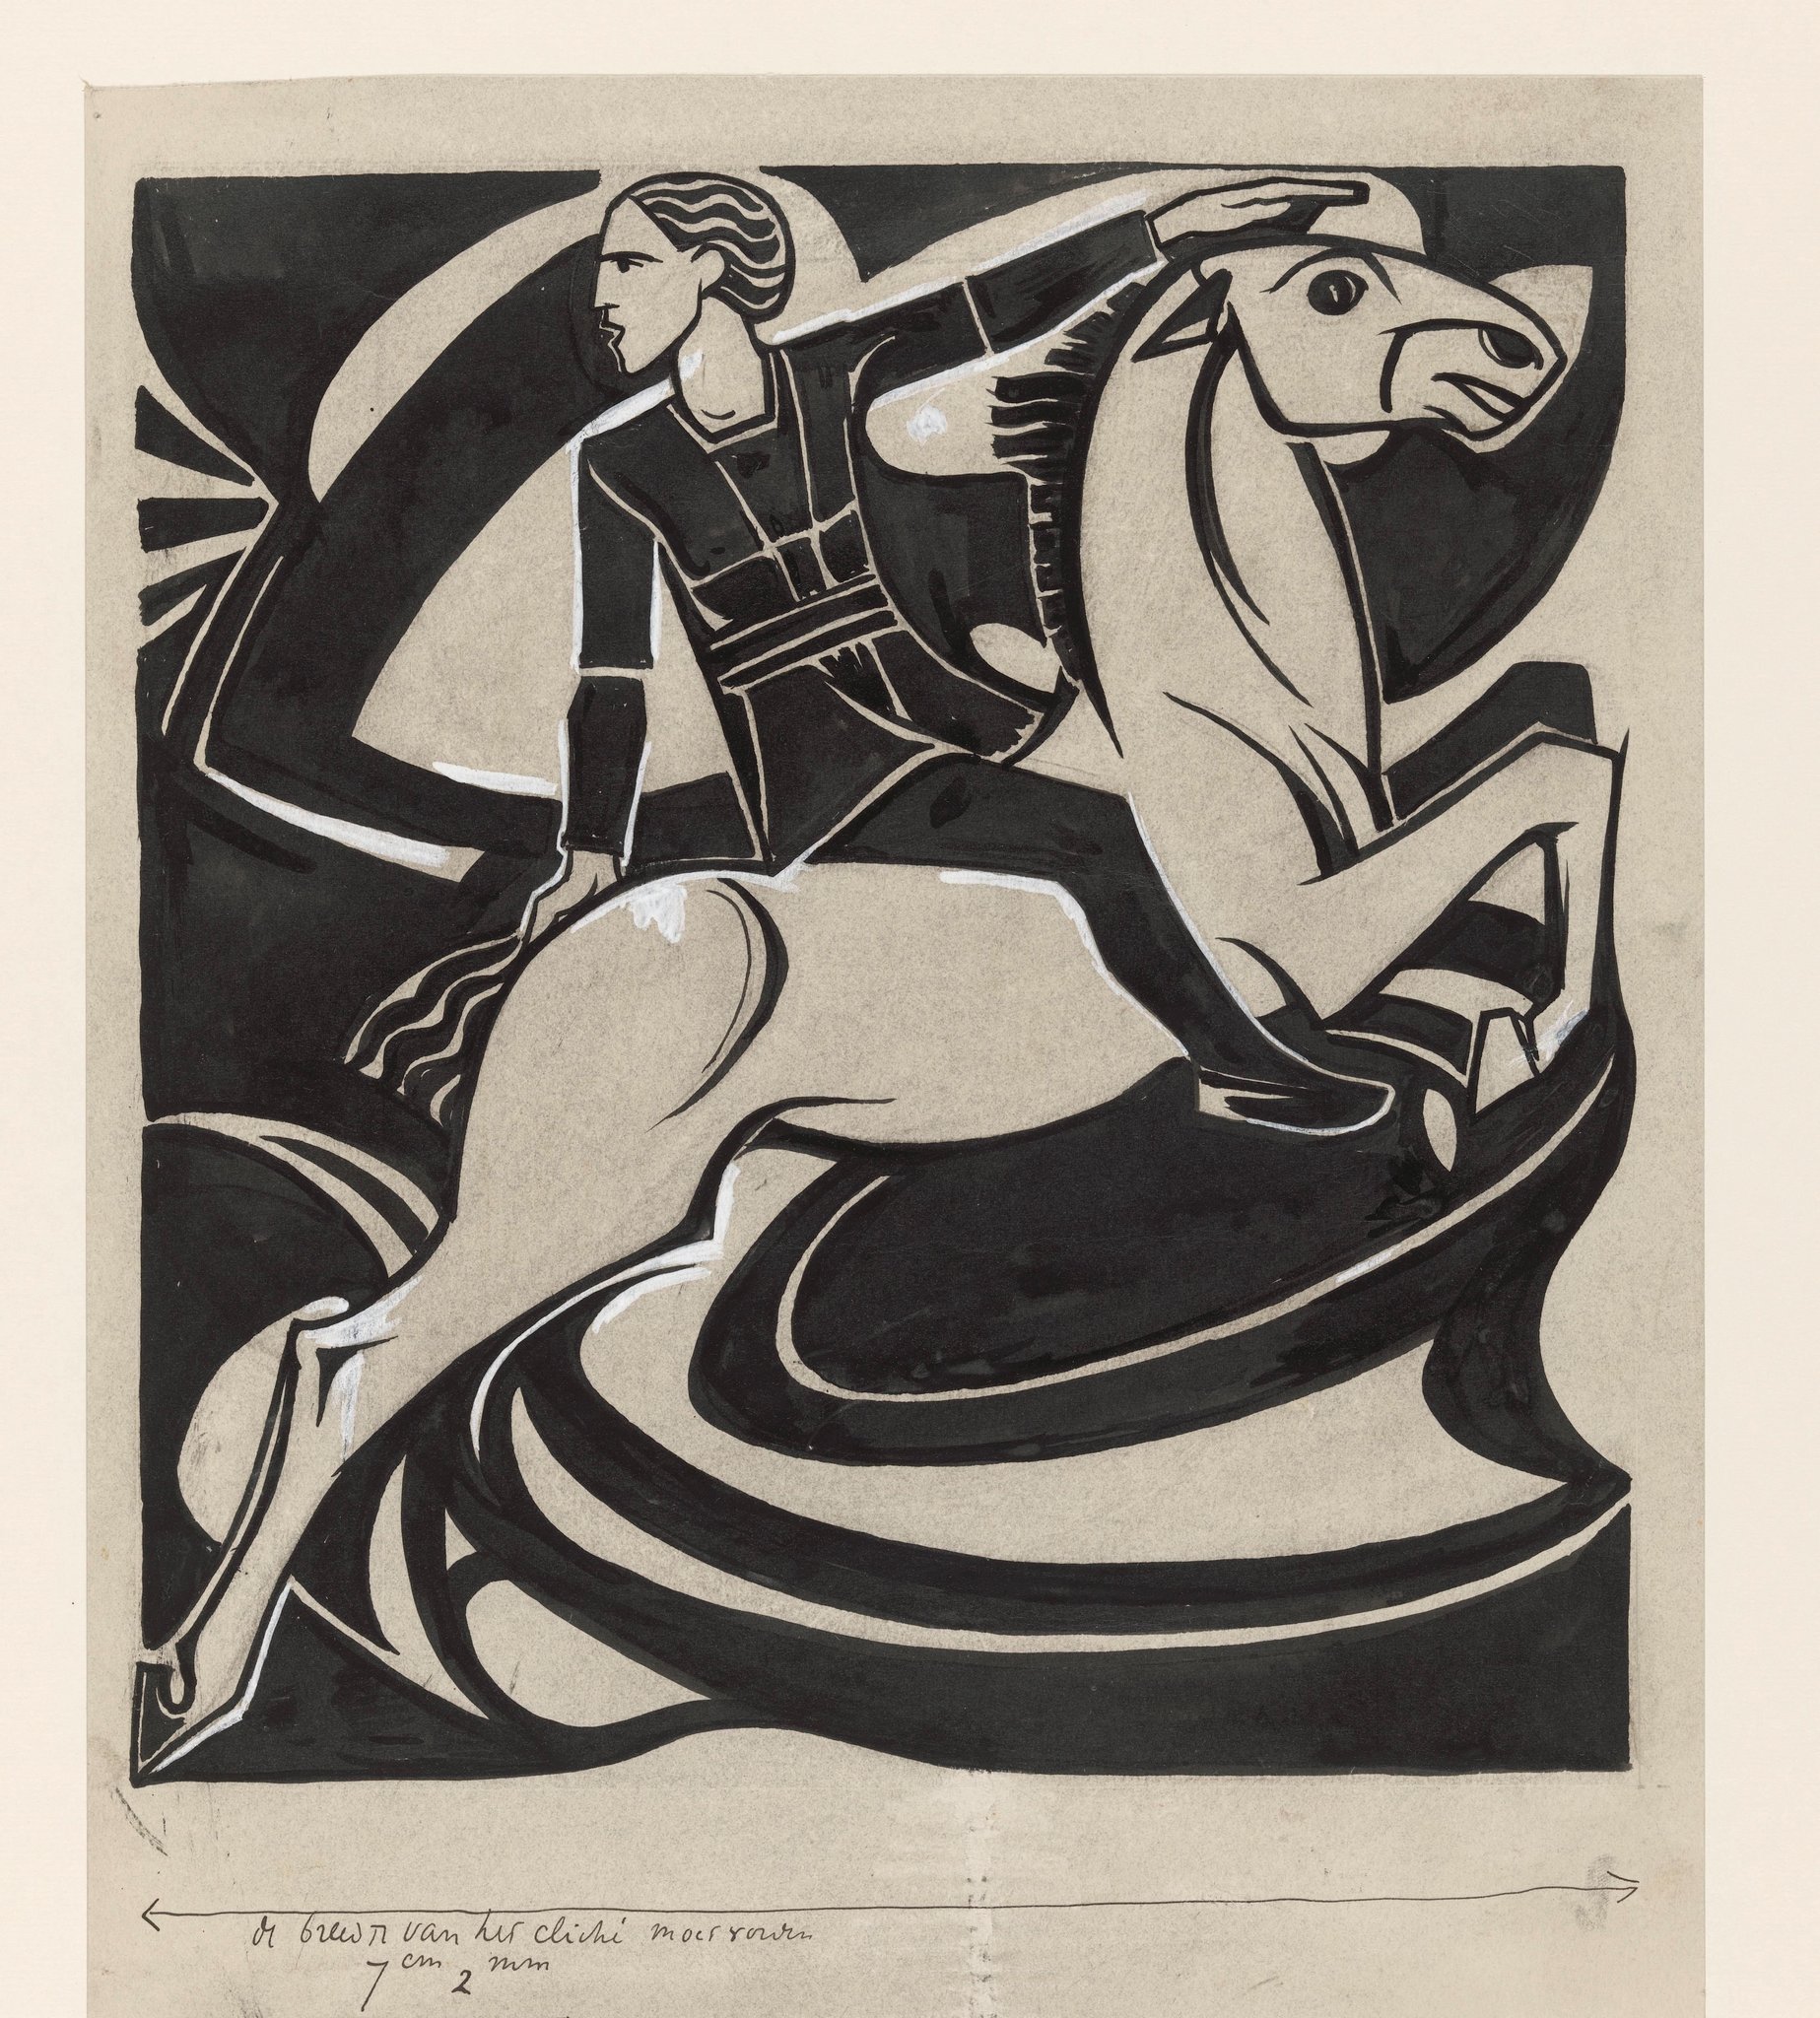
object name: drawing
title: Man te paard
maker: richard nicolaüs roland holst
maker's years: 1868-1938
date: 1878-1938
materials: paint, paper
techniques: brush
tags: riding a horse, ass, or mule; rider, horseman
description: Ontwerp voor vignet voor Sociale Verzekeringsgids.